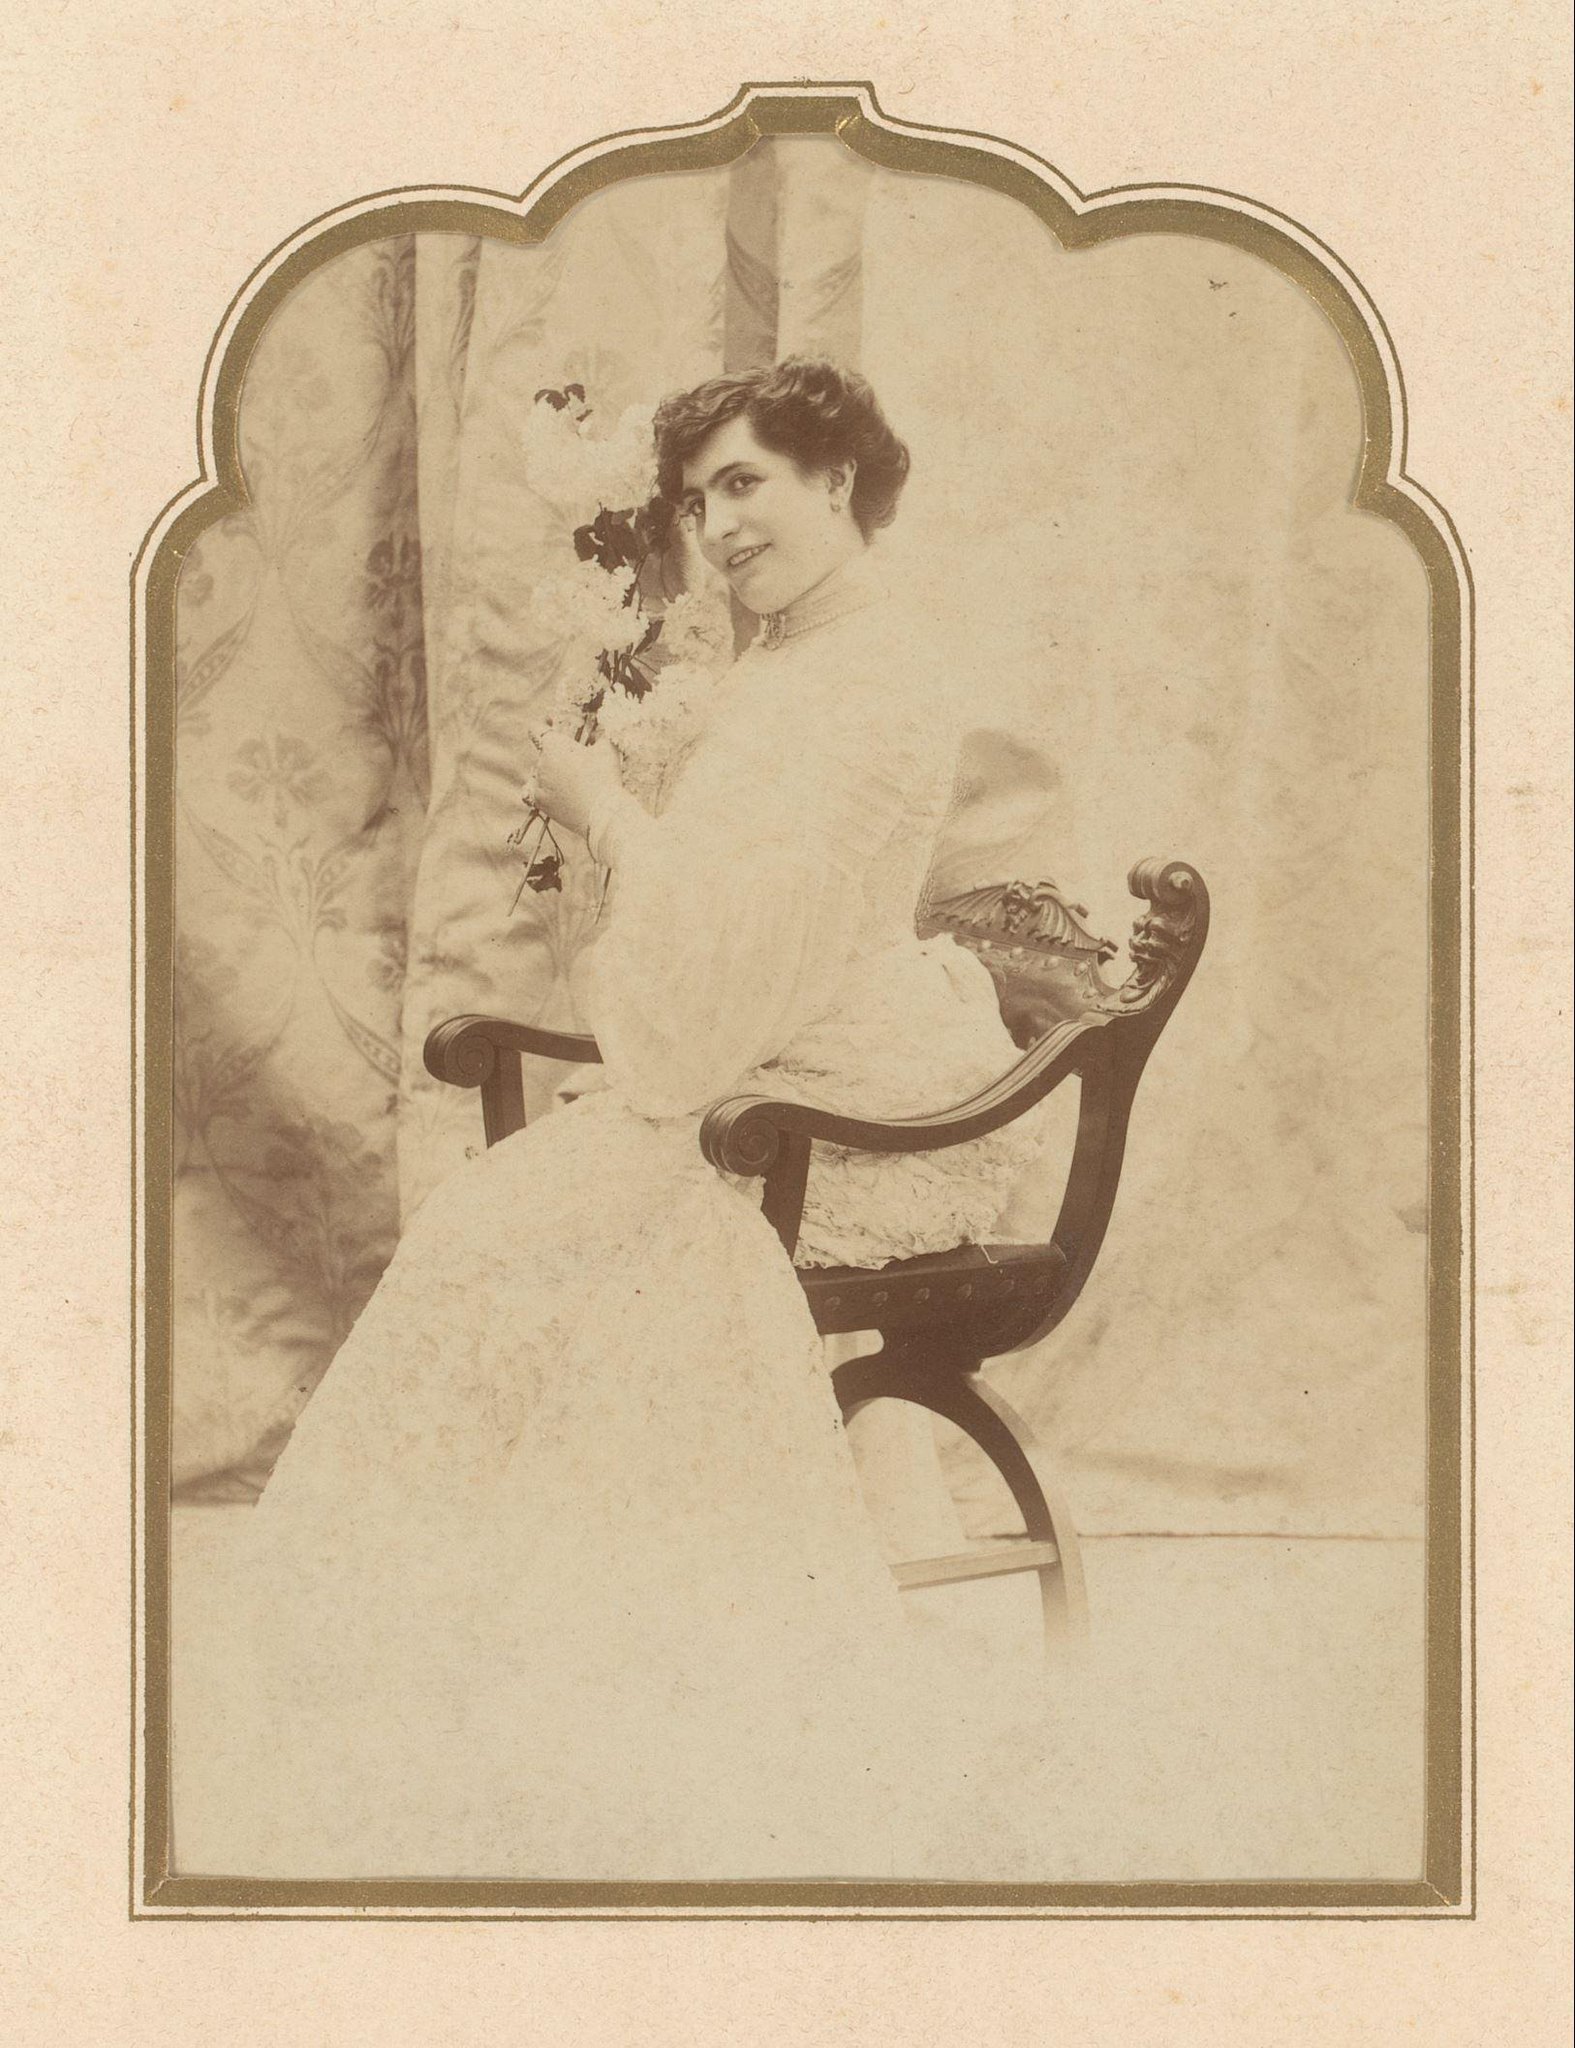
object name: cabinet photograph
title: Portret van een zittende vrouw in wit kanten japon met bloemen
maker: édouard stebbing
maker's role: fotograaf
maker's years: 1836-1915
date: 1880-1910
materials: cardboard, photographic support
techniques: albumen print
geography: paris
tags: cut flowers; nosegay, bunch of flowers, historical persons - bb - woman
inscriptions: inscription: ‘Professeur Stebbing/ Photgraphie hors concours/ Boulevard des Italiens/ et/ 30, Rue de Grammont/ Paris’